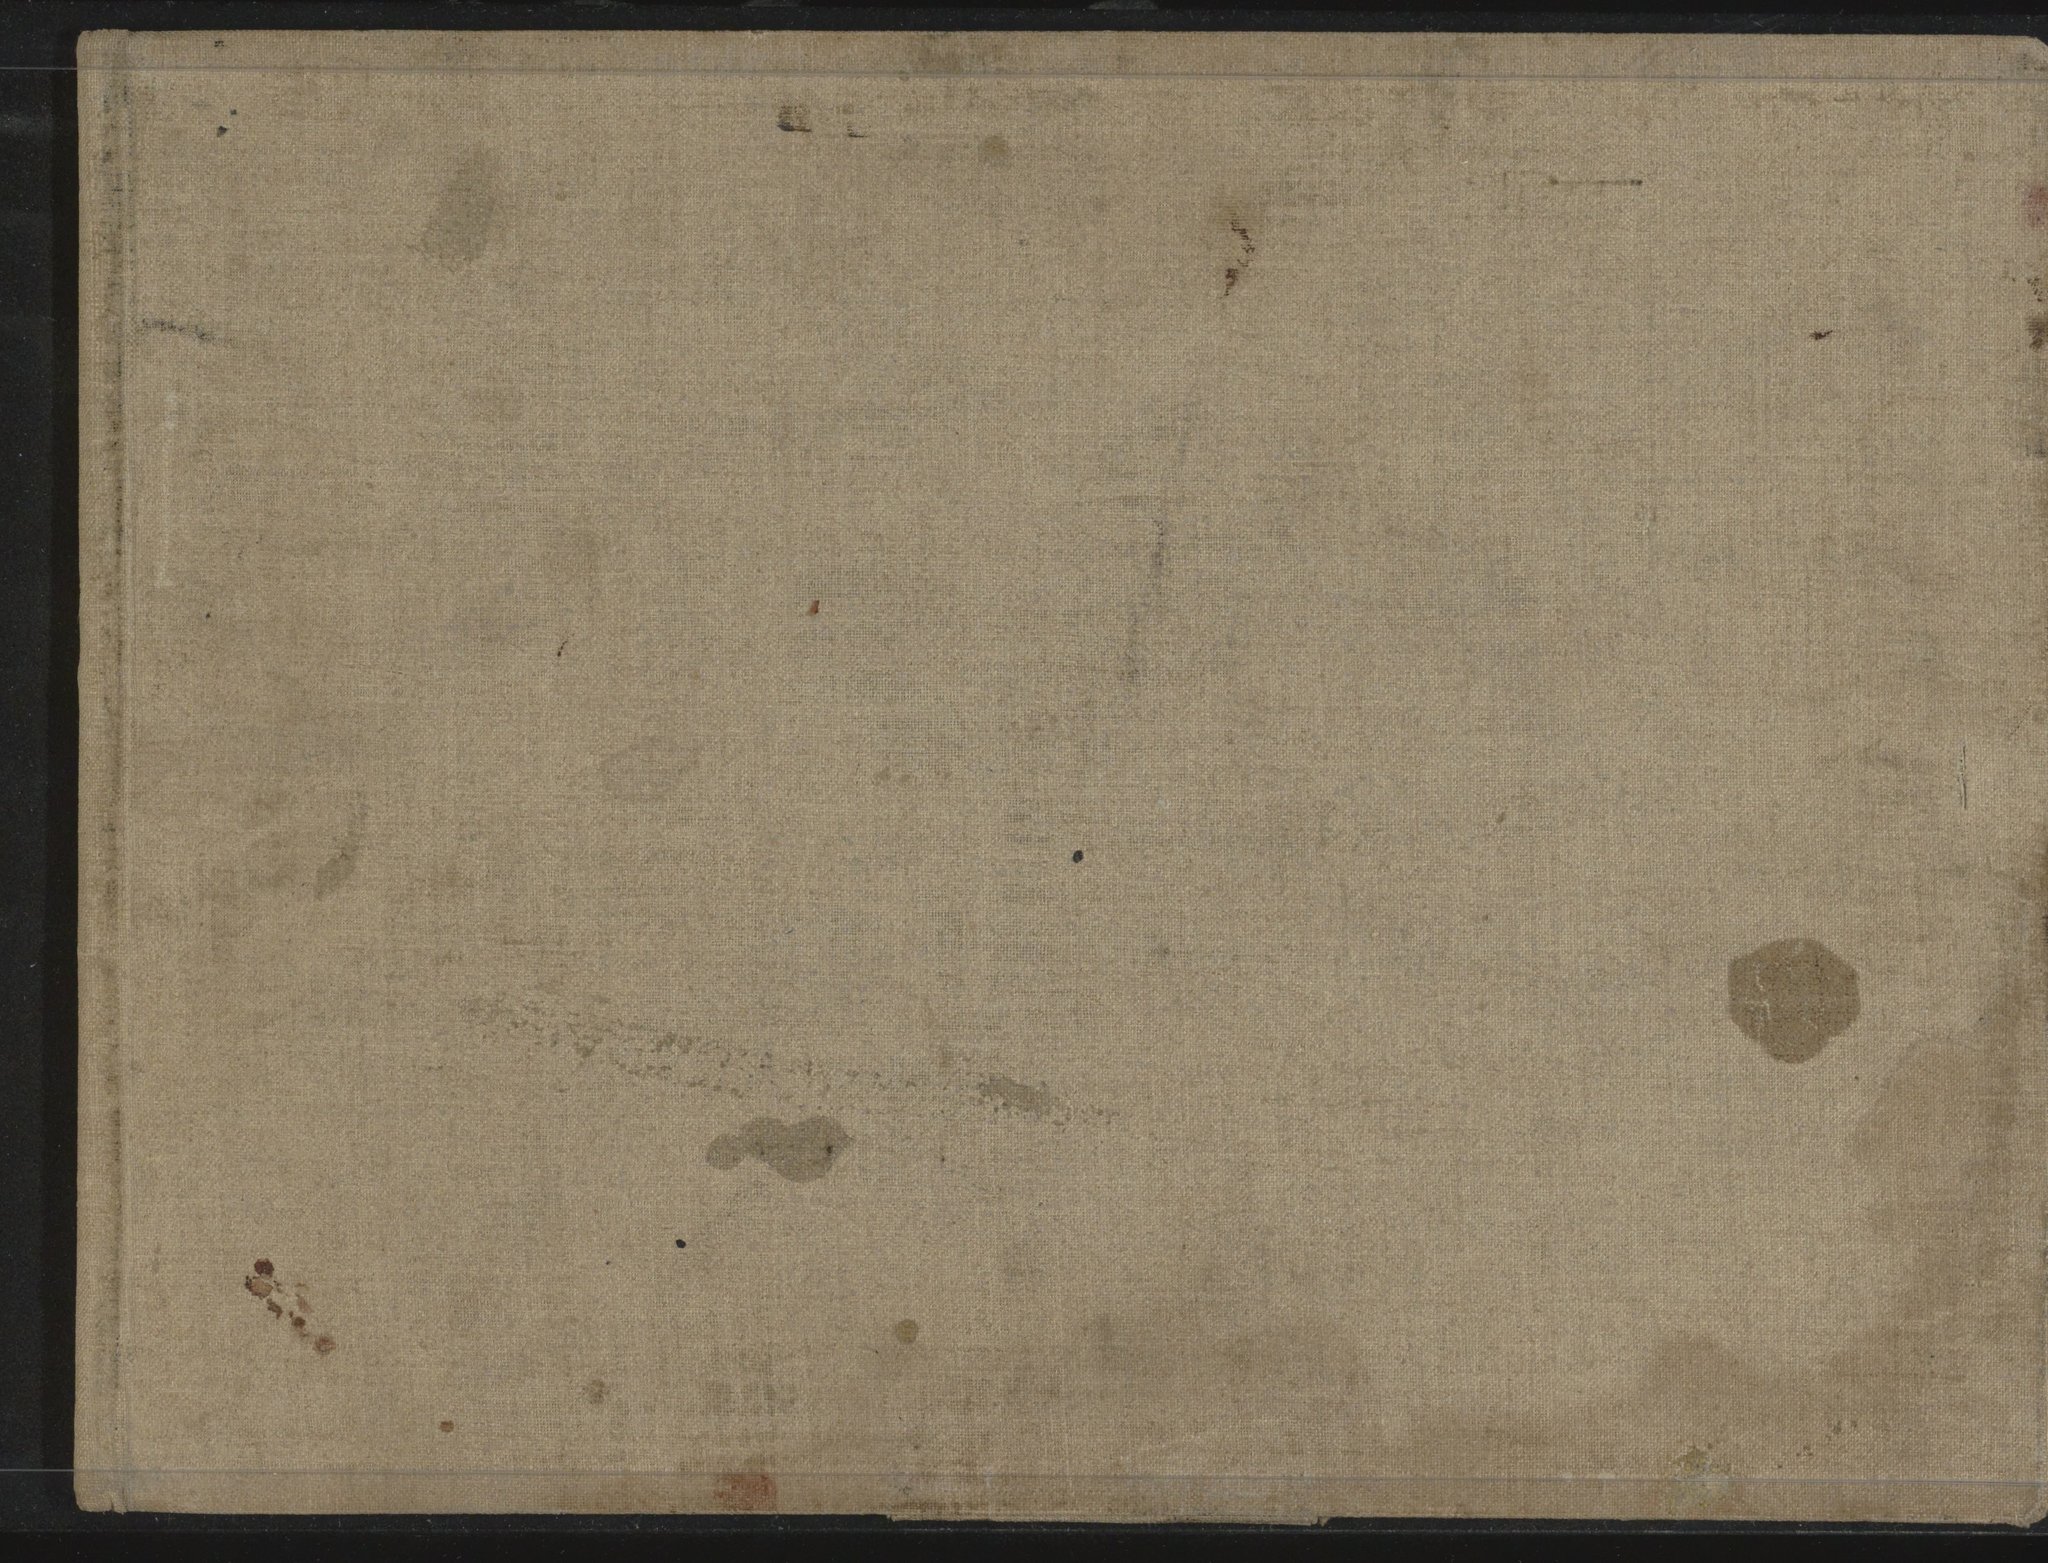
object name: sketchbook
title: Schetsboek met 9 bladen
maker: george hendrik breitner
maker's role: draughtsman, painter, print maker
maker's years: 1857-1923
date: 1886-1923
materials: cardboard, chalk, linen, paper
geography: amsterdam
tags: adult woman, adult man, four-wheeled, animal-drawn vehicle, e.g.: cab, carriage, coach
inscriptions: collector's mark: Lugt 2228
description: Schetsboek met 9 bladen, waarvan 3 betekend met een paard-en-wagen en figuurstudies.